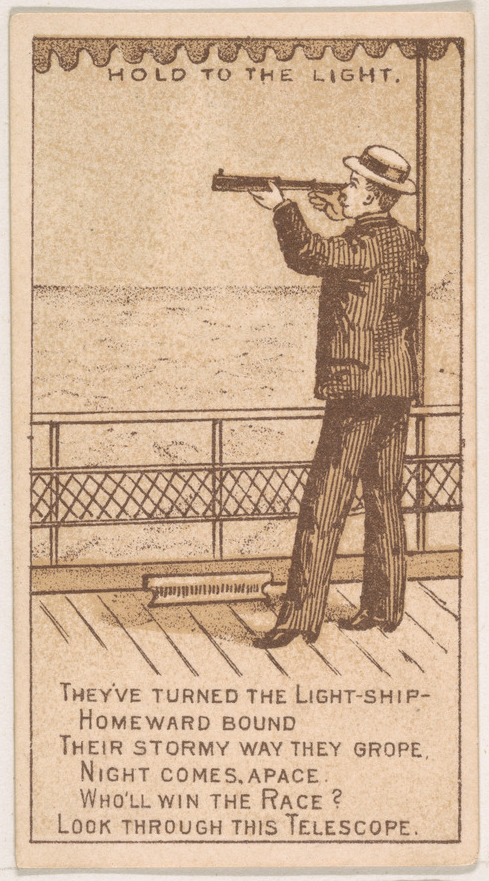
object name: print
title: They've Turned the Light-Ship Homeward Bound..., from the Magic Changing Cards series (N223) issued by Kinney Tobacco Company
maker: kinney brothers tobacco company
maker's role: publisher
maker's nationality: american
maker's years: 1869-2011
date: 1889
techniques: color lithograph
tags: men,profiles